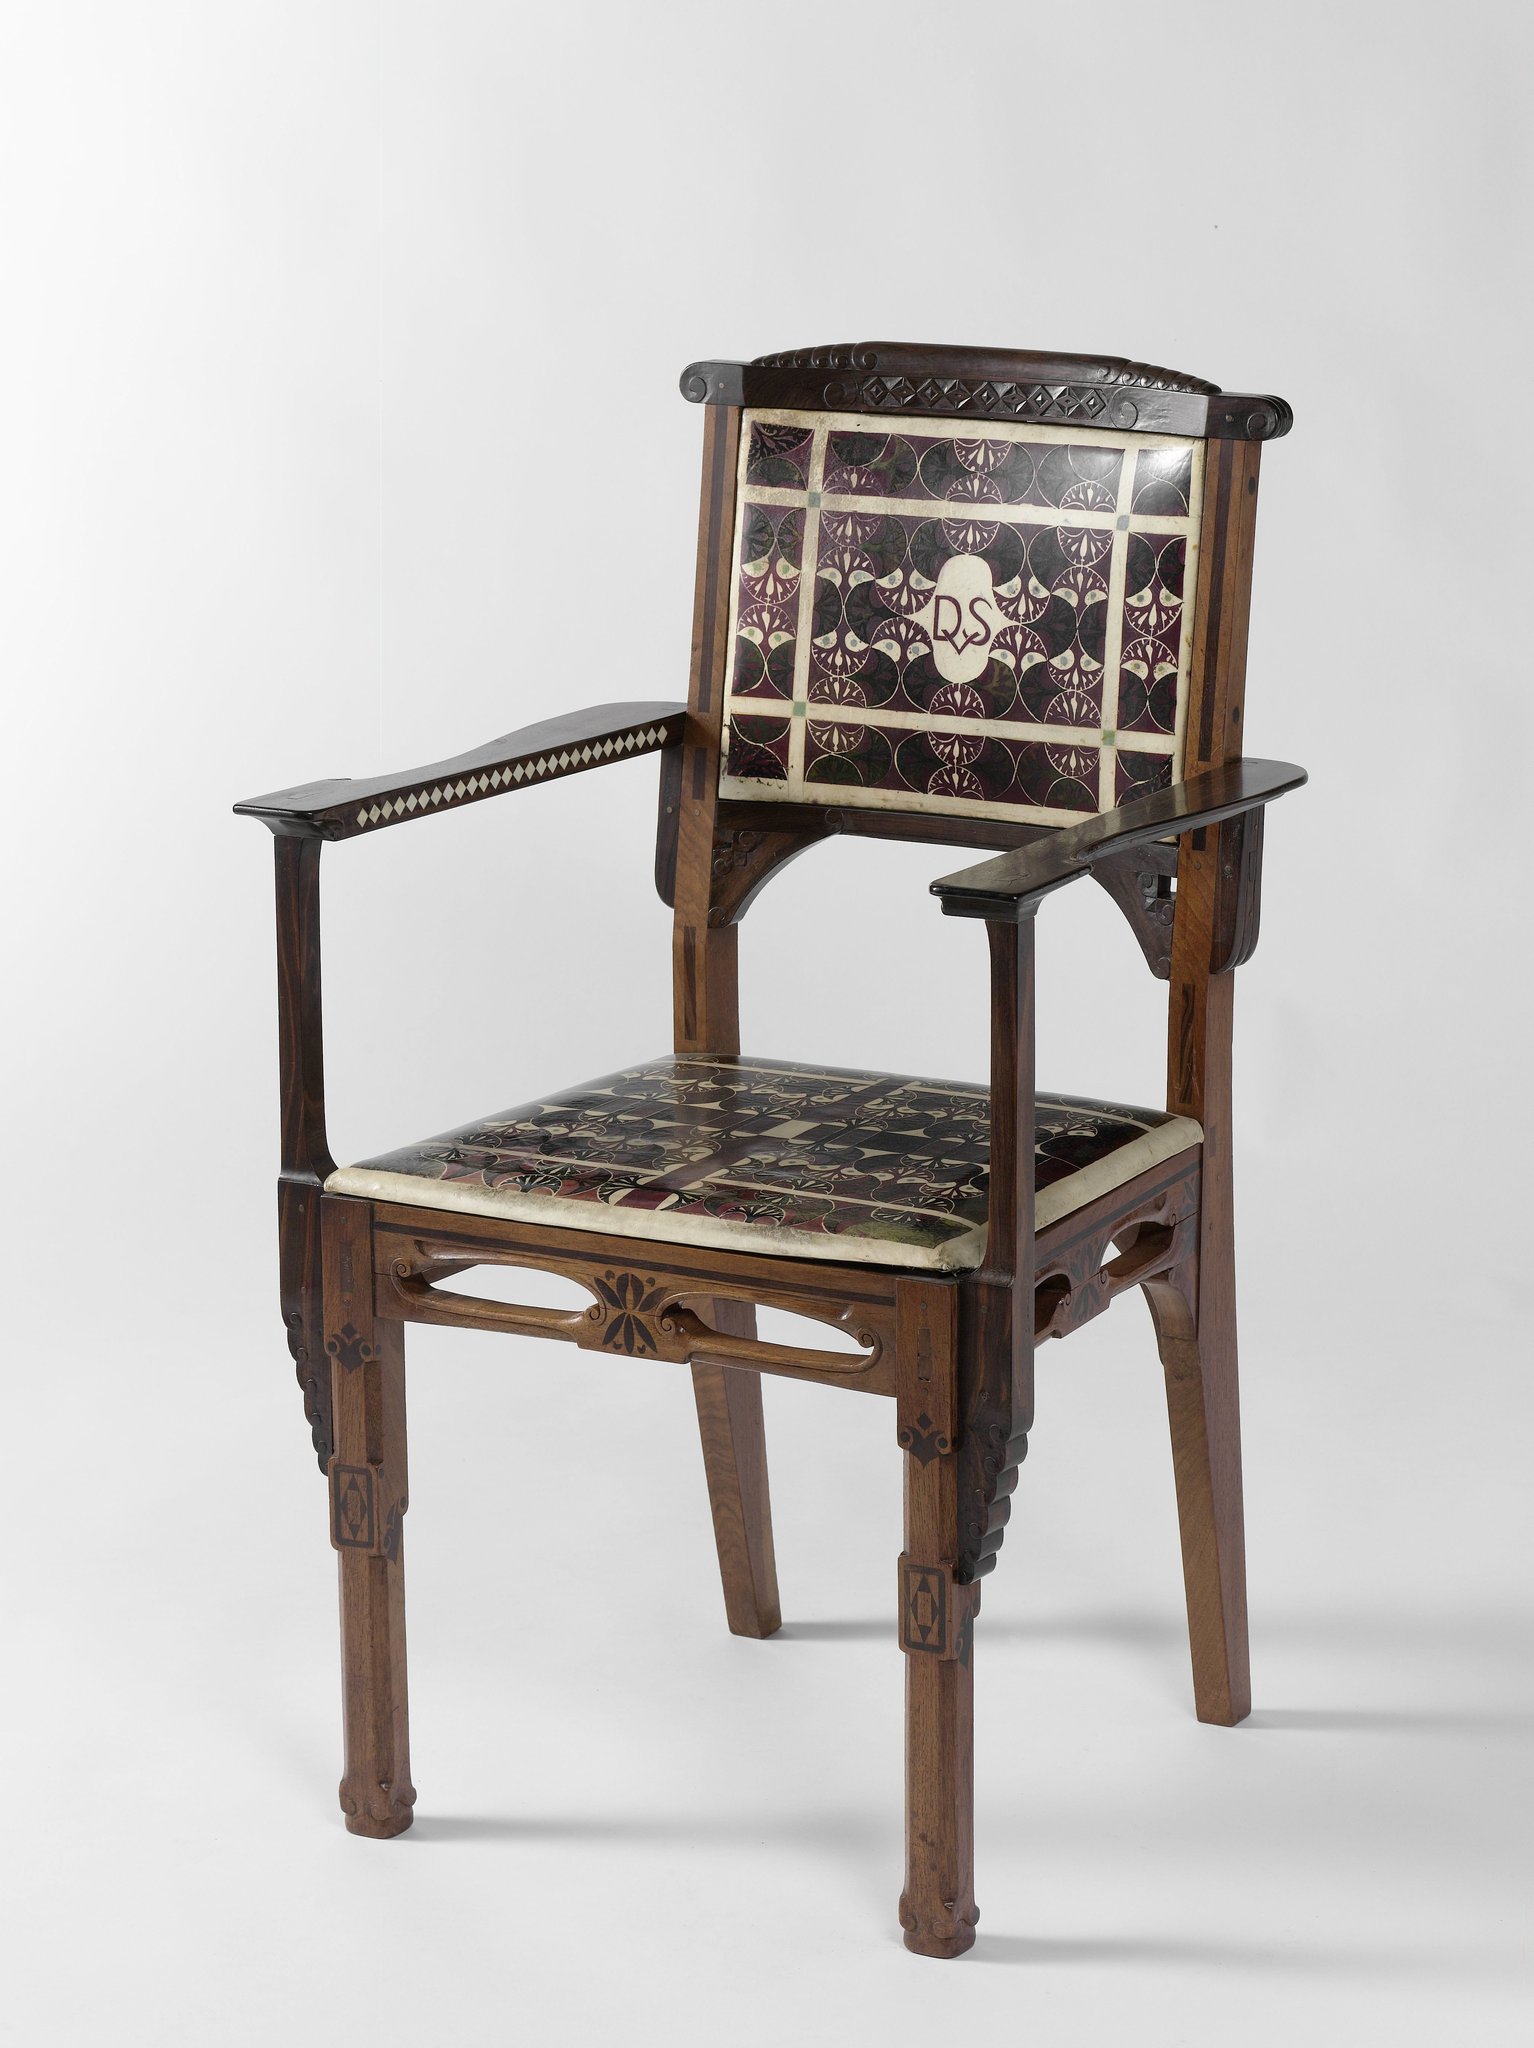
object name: armchair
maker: carel adolph lion cachet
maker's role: draughtsman, print maker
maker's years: 1864-1945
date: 1905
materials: wood, ivory, parchment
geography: amsterdam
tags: ornaments ~ art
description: The workshop of the Amsterdam interior decorator and fine art dealer Van Wisselingh & Co had a special department for producing batik, a resist-dyeing technique originally from Java. This technique was used for the ornamentation of the parchment seat and back of this chair. It was commissioned by Mr and Mrs Dentz van Schaick, whose monogram DvS graces its back.